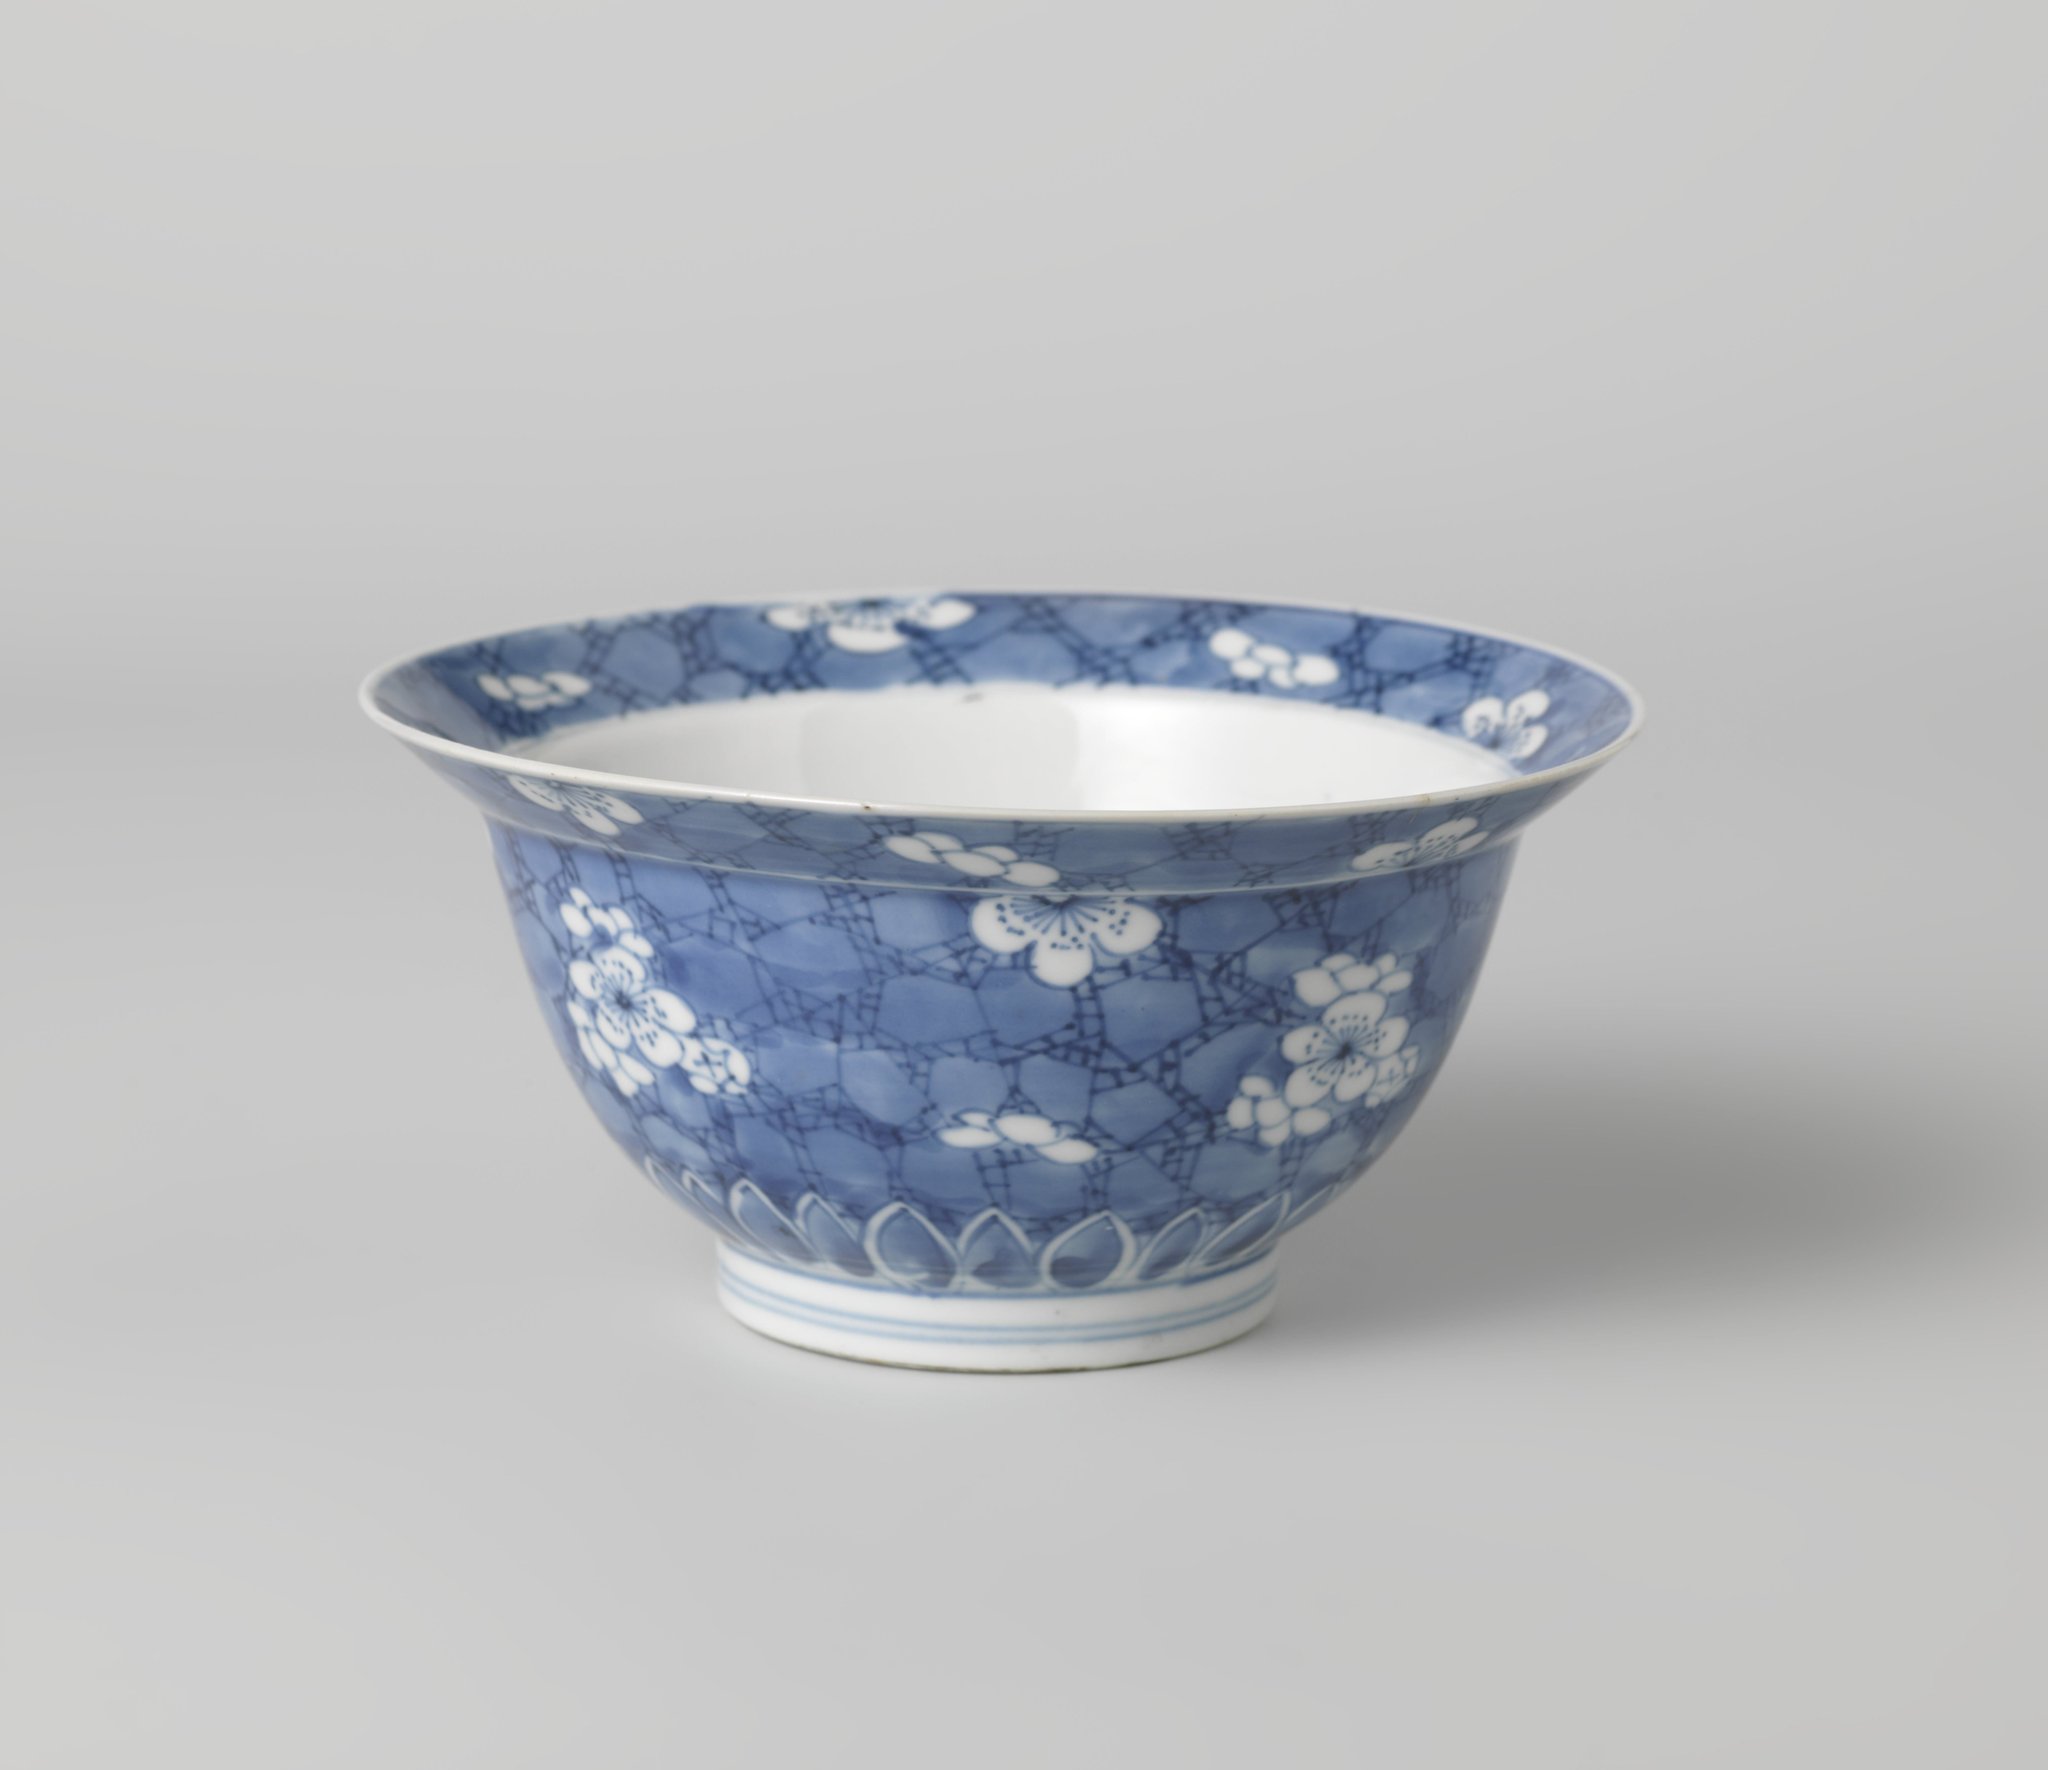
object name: bowl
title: Bowl (klapmuts) with plumblossom on 'crackled ice'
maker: Anonymous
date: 1680-1720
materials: cobalt, glaze, paint, porcelain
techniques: firing, turning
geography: china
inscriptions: mark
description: Kom (klapmuts) van porselein, beschilderd in onderglazuur blauw. Op de buitenwand, de bodem en binnen- en buitenrand 'crackled ice' met uitgespaarde pruimenbloesems. De onderzijde van de buitenwand met een band van puntige bladmotieven. Gemerkt op de onderzijde met een wierookbrander in een dubbele cirkel. Blauw-wit.